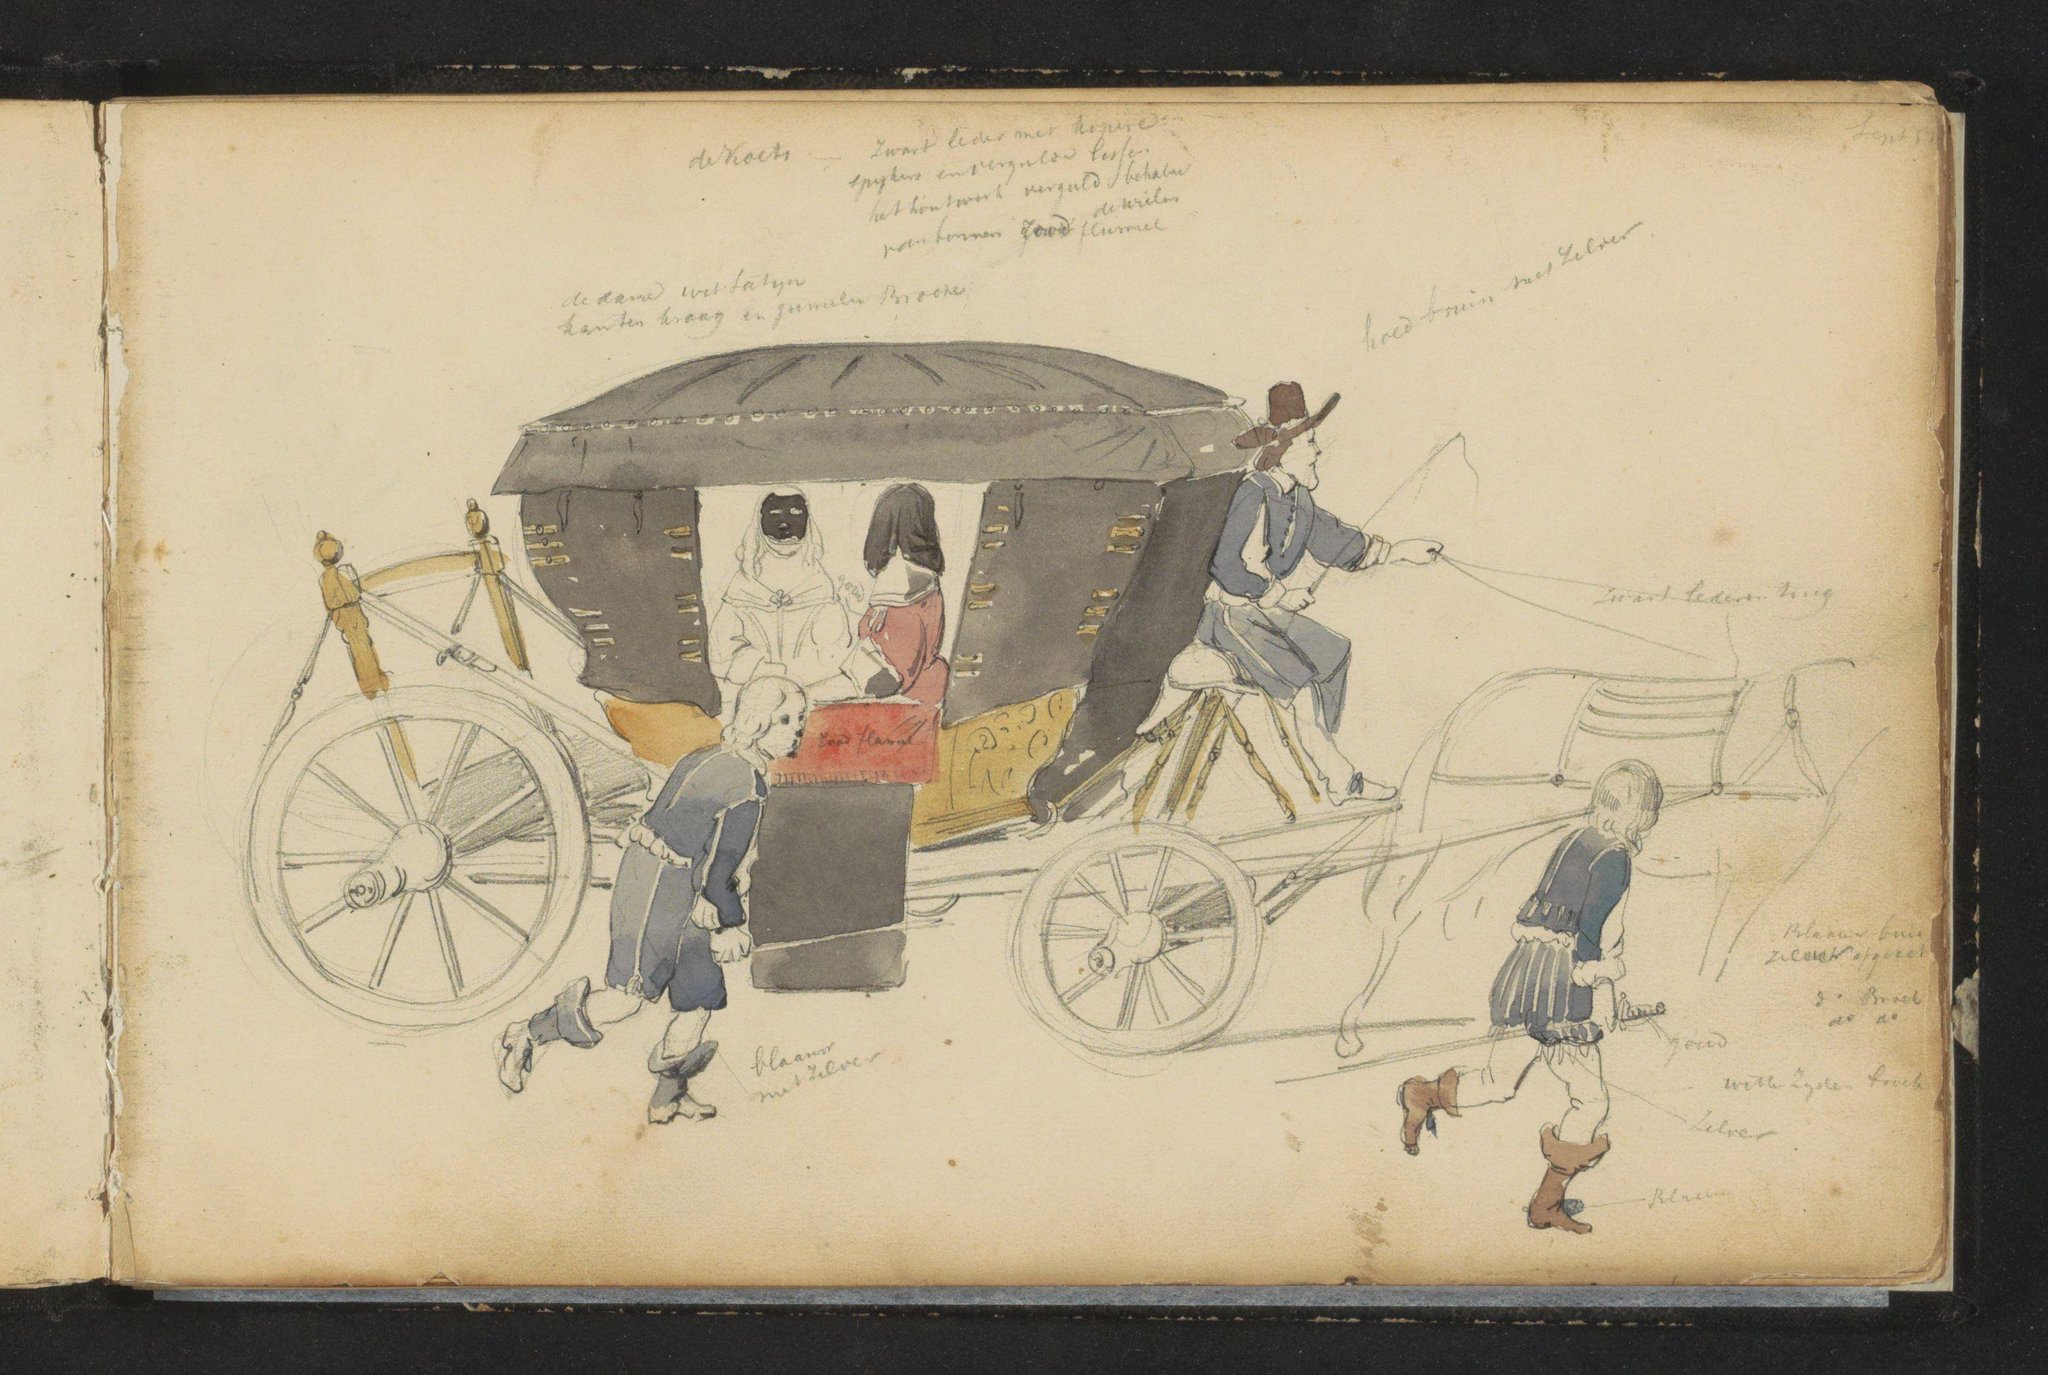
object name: sketchbook leaf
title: Twee vrouwen in een koets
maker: cornelis springer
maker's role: draughtsman, painter, print maker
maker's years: 1817-1891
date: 1809-1852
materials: paper, pencil, watercolor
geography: netherlands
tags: four-wheeled vehicle drawn by one animal, adult woman, youth, adolescent, clothes, costume (+ women's clothes), clothes, costume (+ men's clothes)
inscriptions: date: ‘Sept 52’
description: In een koets zitten twee vrouwen. De linker vrouw is gemaskerd. Op de bok zit de koetsier. Naast de koets lopen twee jonge mannen in zeventiende-eeuwse kleding. Blad 12 uit een schetsboek met 91 bladen.